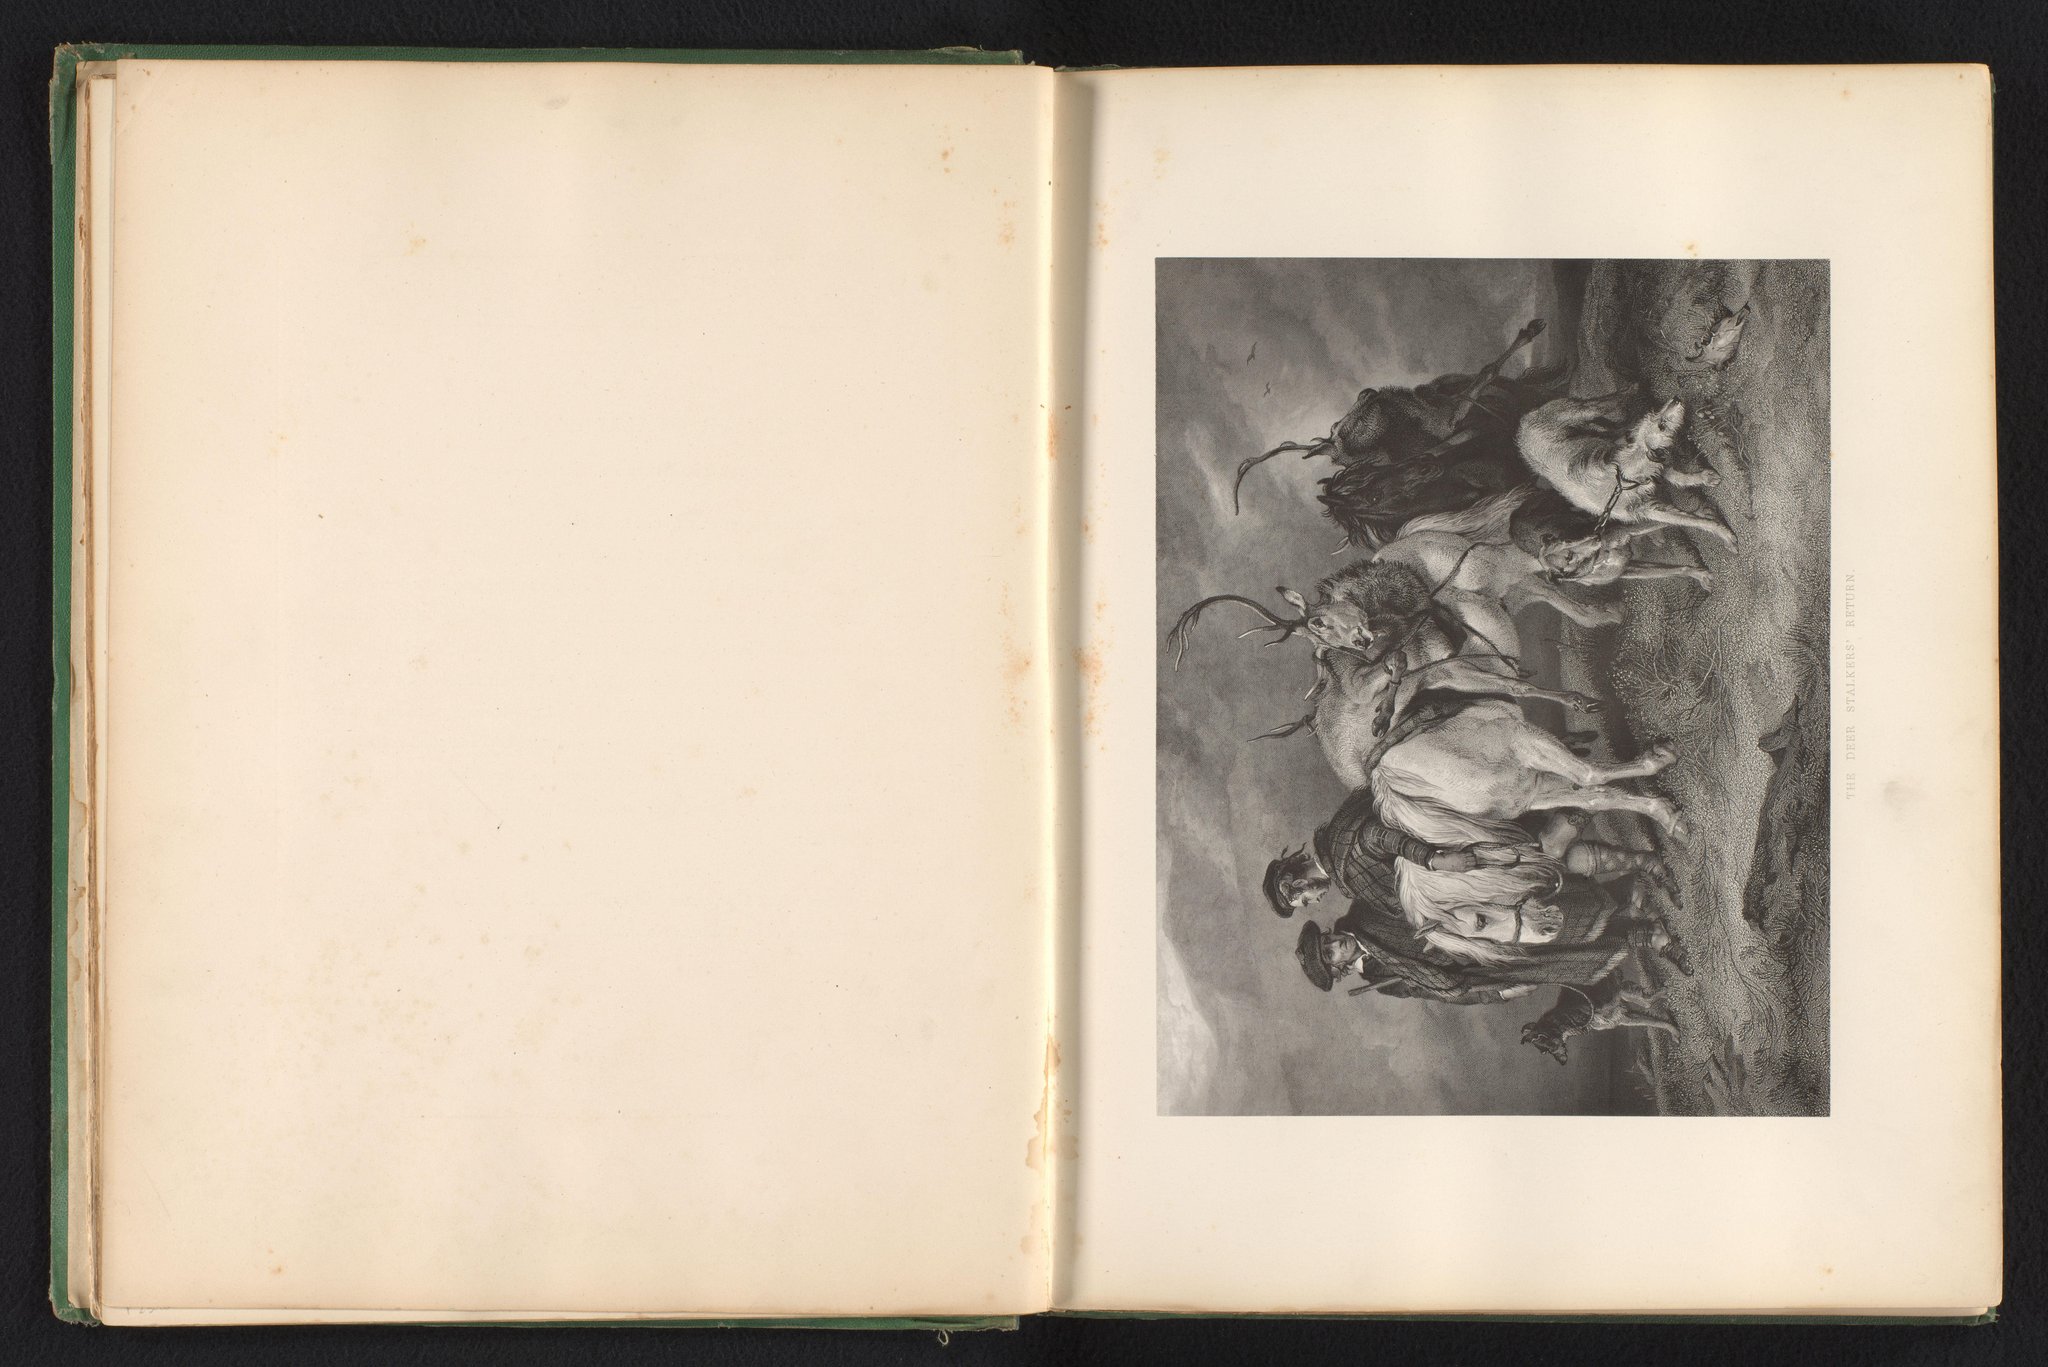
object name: photomechanical print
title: Reproductie van een prent naar een schilderij van hertenjagers in Schotland door Edwin Landseer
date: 1878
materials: paper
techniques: woodburytype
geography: london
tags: hunter, return from the hunt